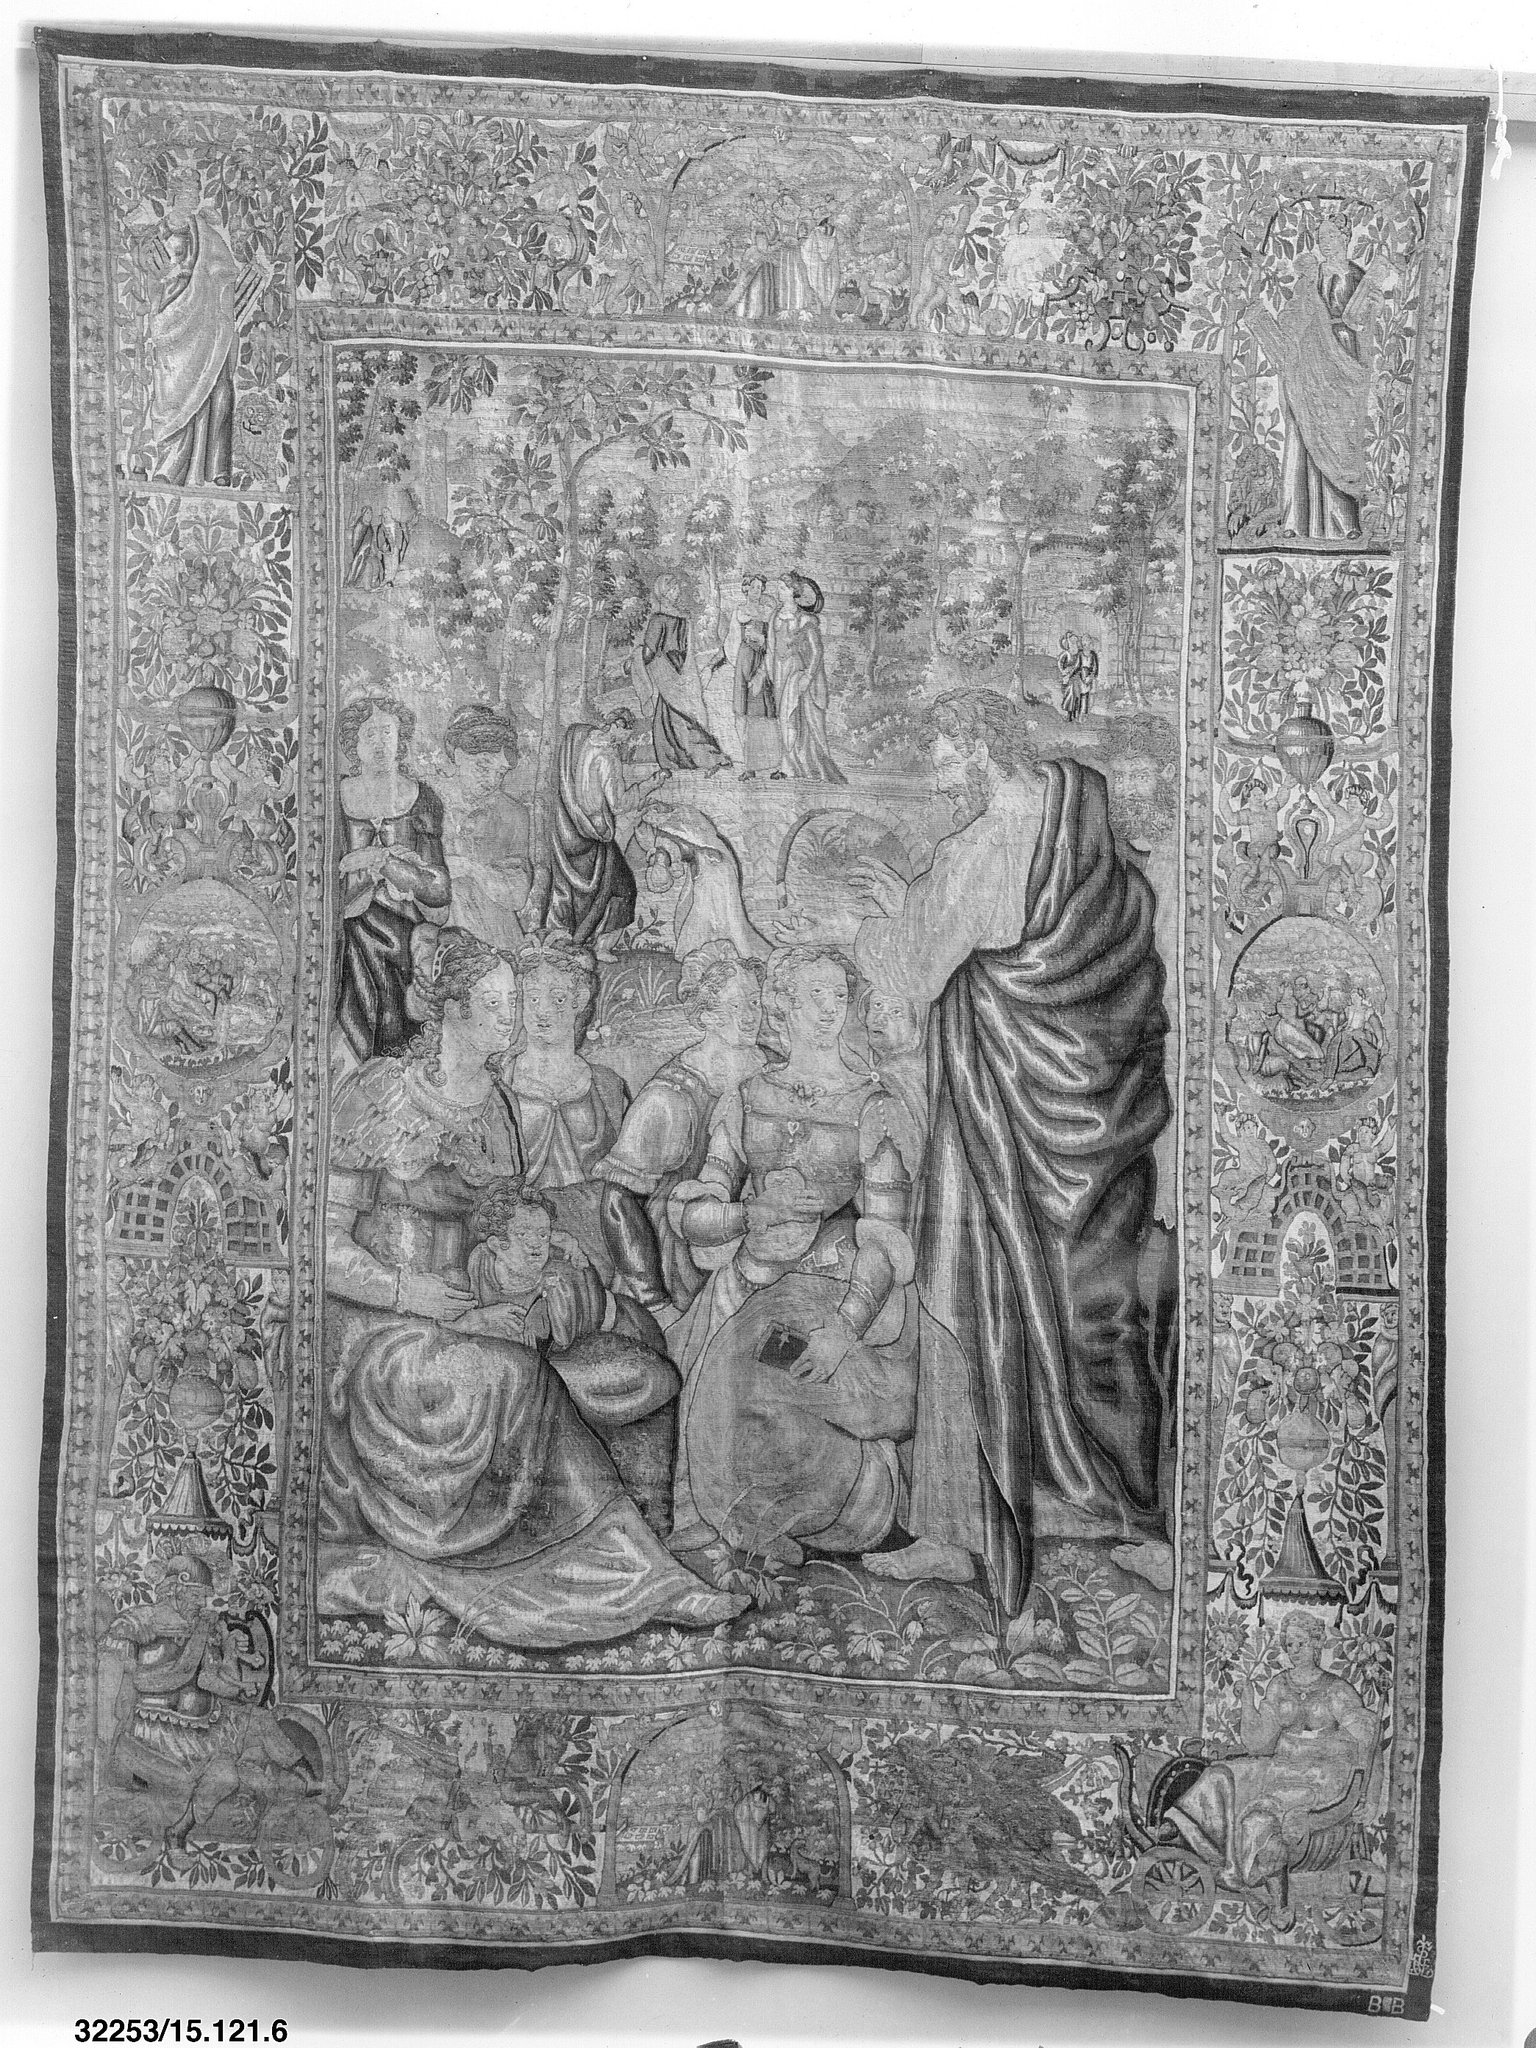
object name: tapestry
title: Paul Preaching at Philippi from a set of Scenes from the Life of Saint Paul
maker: raphael (raffaello sanzio or santi)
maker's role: designer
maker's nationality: italian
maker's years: 1483-1520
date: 1600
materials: silk, wool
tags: men,women,saint paul